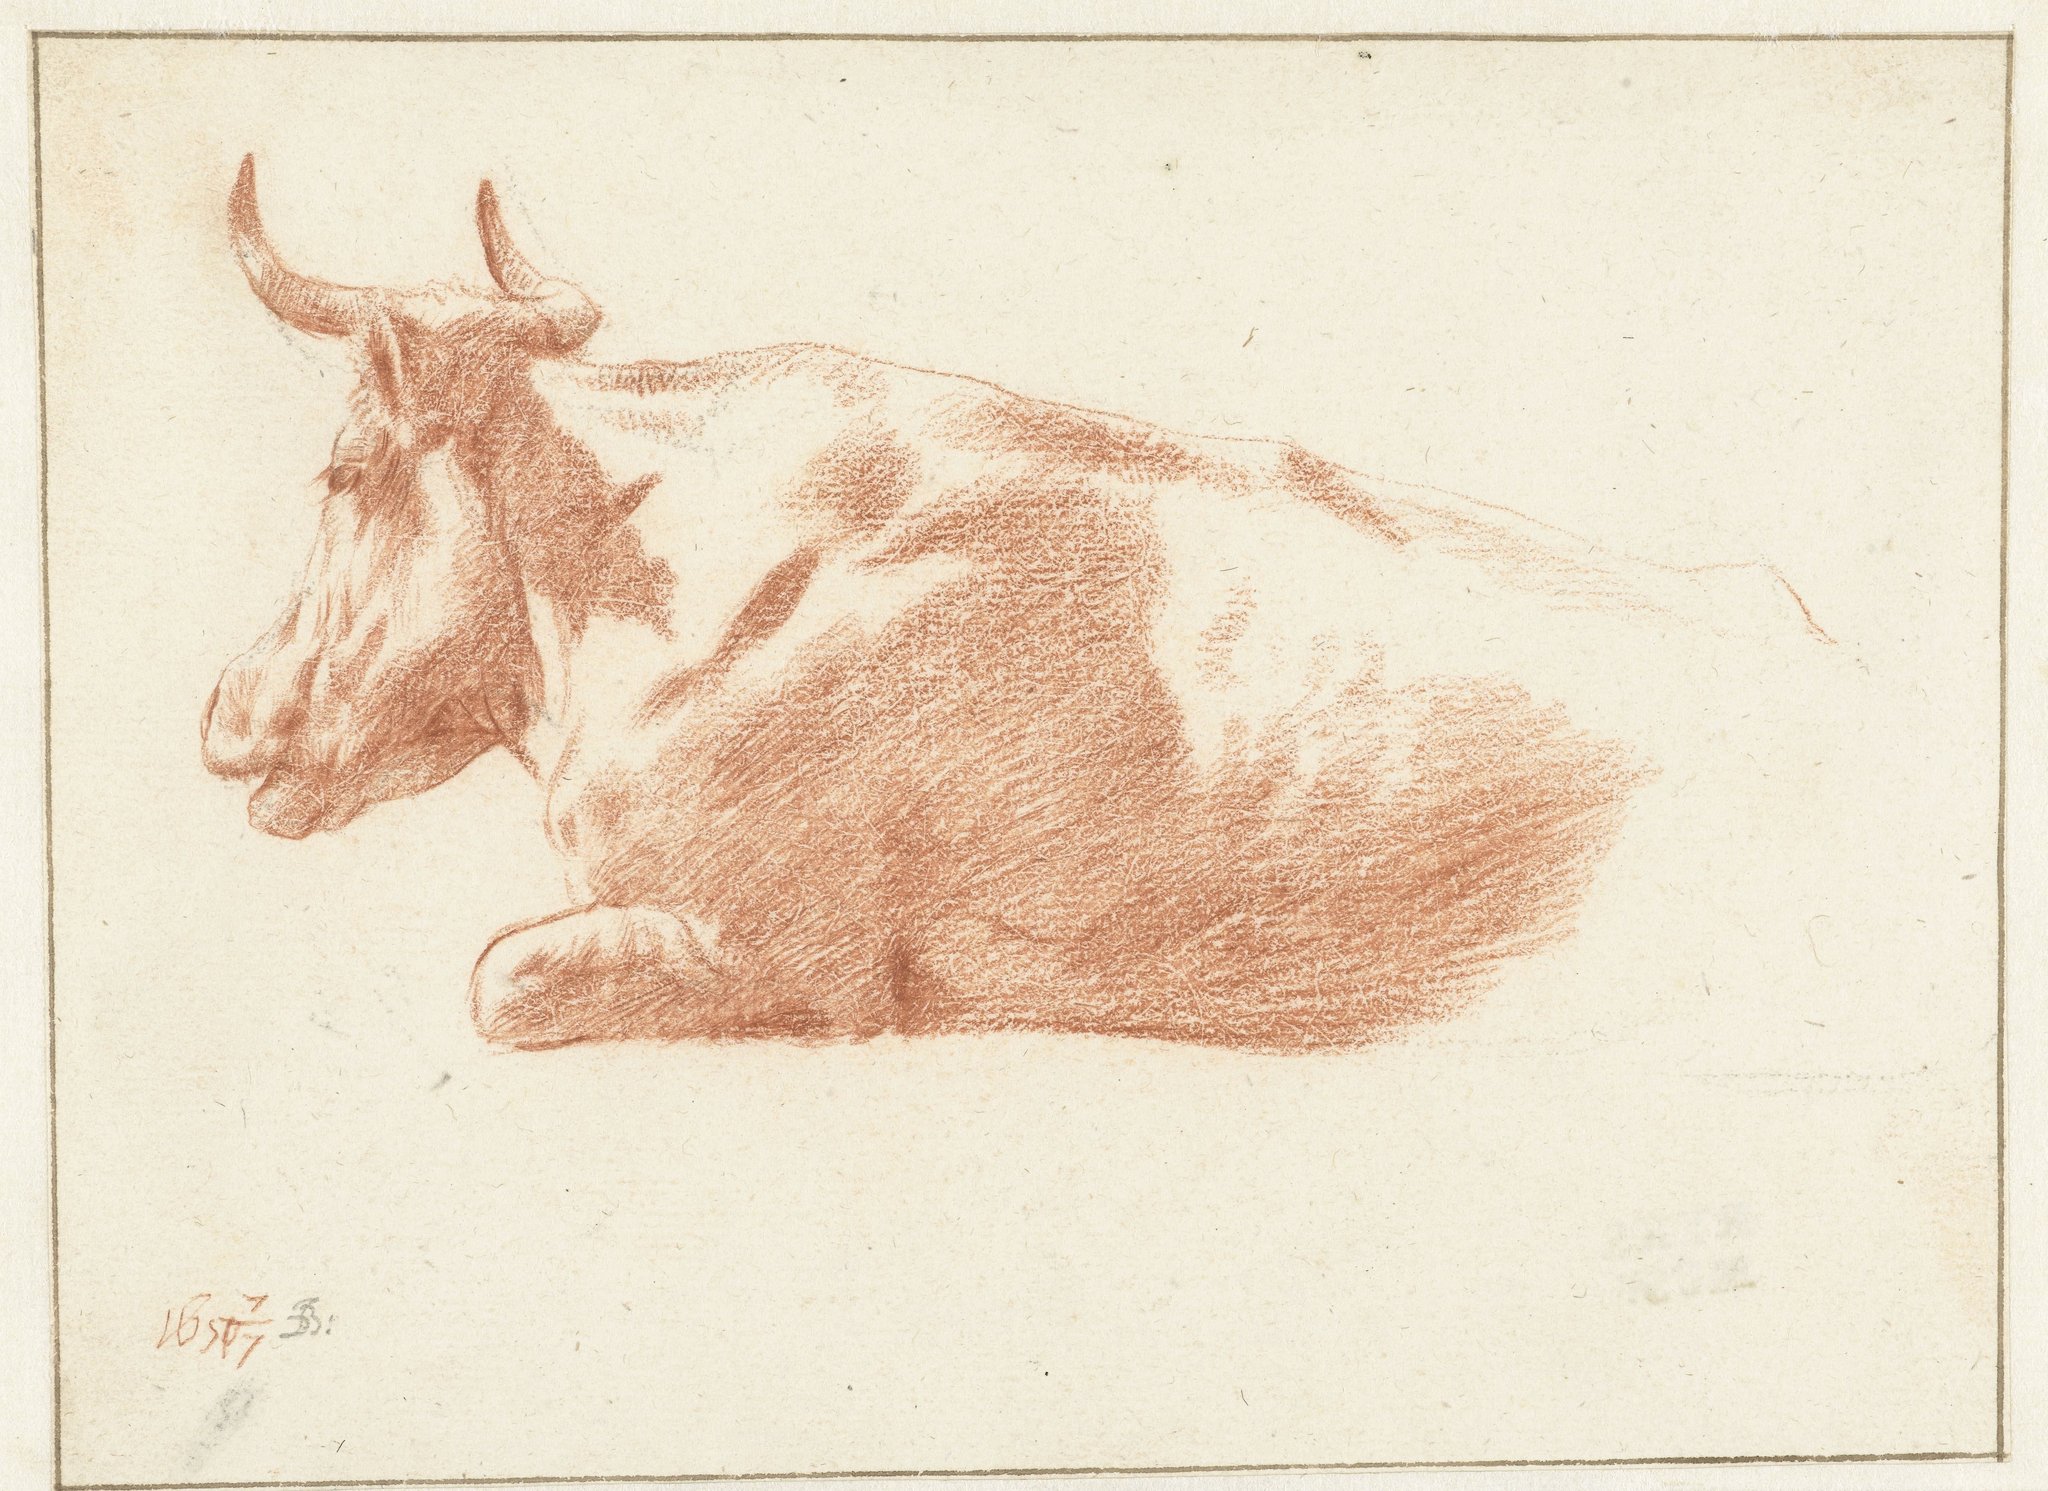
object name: drawing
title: Resting Cow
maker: jan de bray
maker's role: draughtsman, print maker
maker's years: 1627-1697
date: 1651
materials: chalk, paper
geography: haarlem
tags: cow